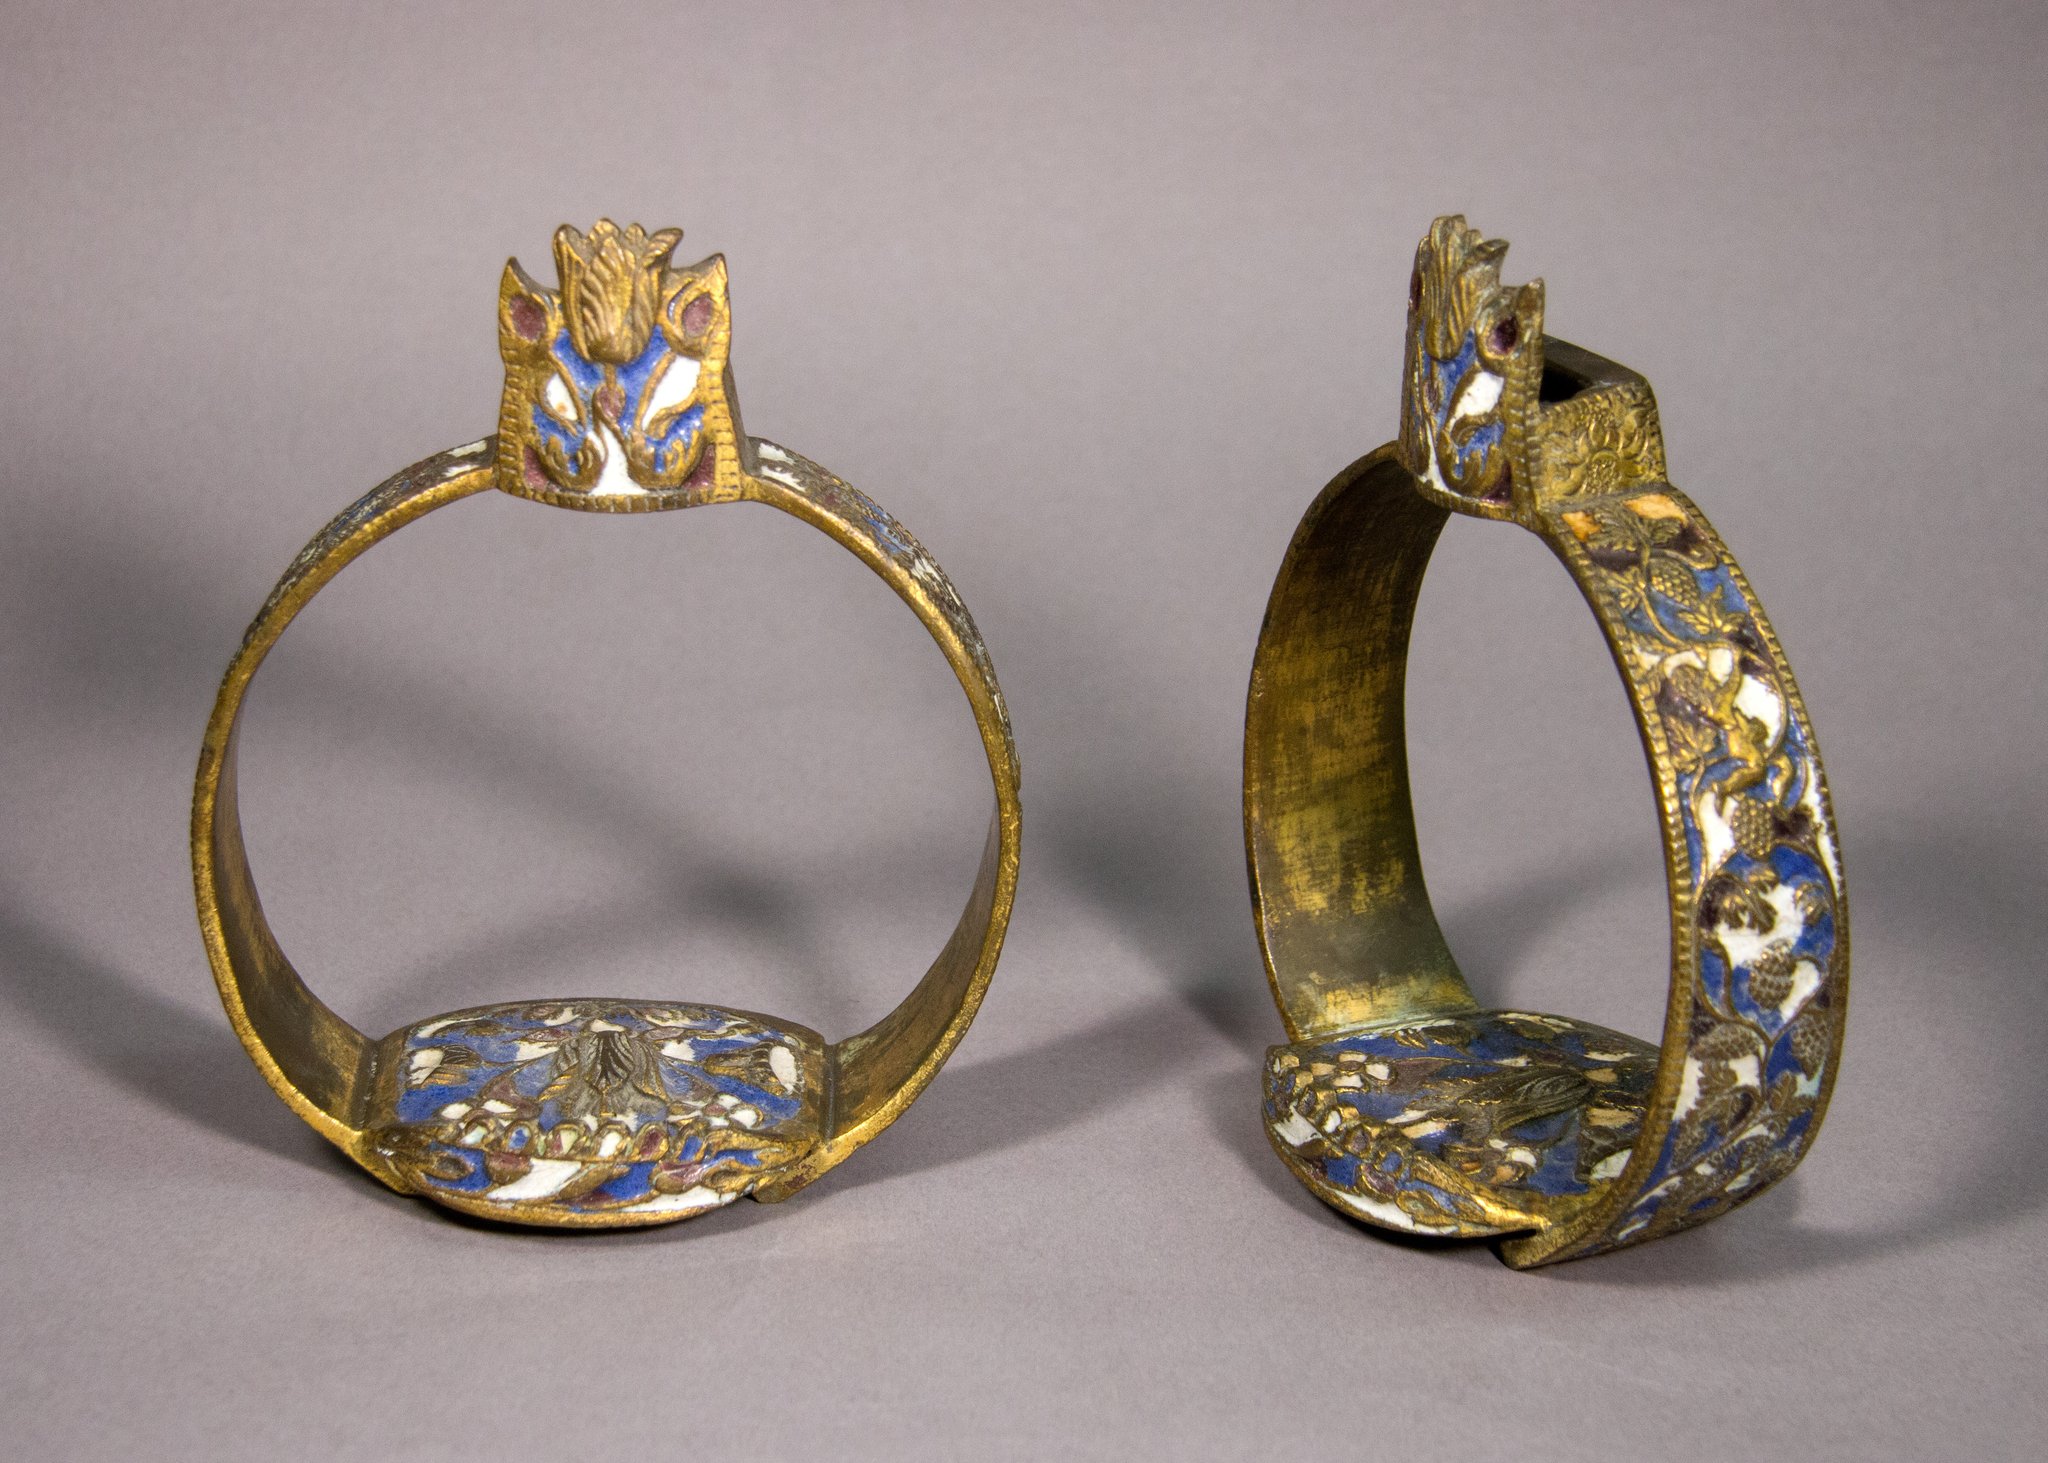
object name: pair of stirrup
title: Pair of Stirrups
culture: british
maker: stephen pilcherd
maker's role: artist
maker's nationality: british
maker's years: 1570-1670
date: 1650-1675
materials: brass, enamel, gold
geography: england